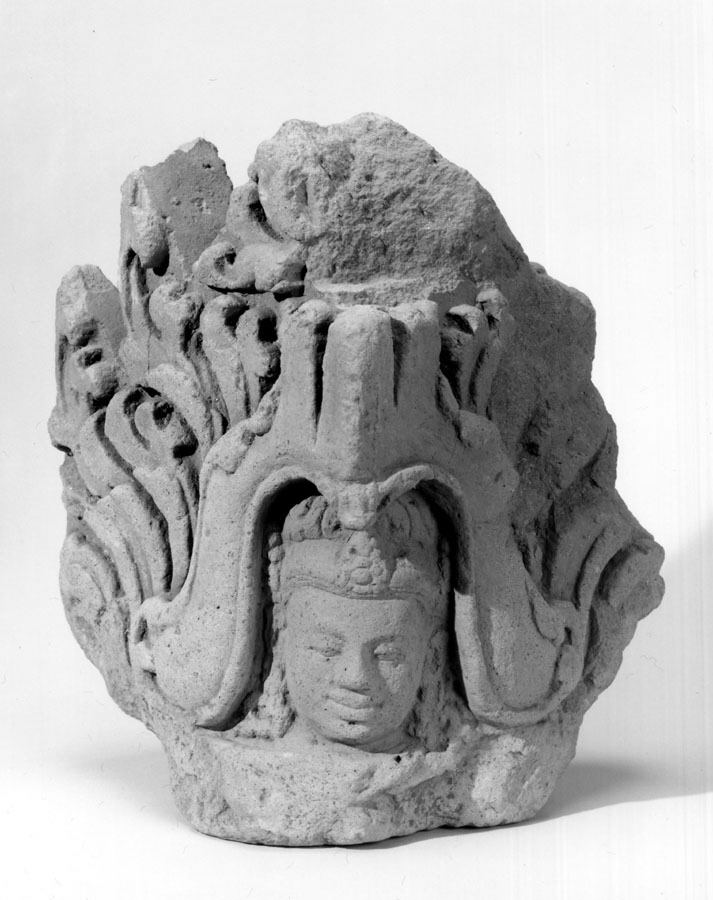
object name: antefix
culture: indonesian, javanese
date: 801-900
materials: terracotta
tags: heads